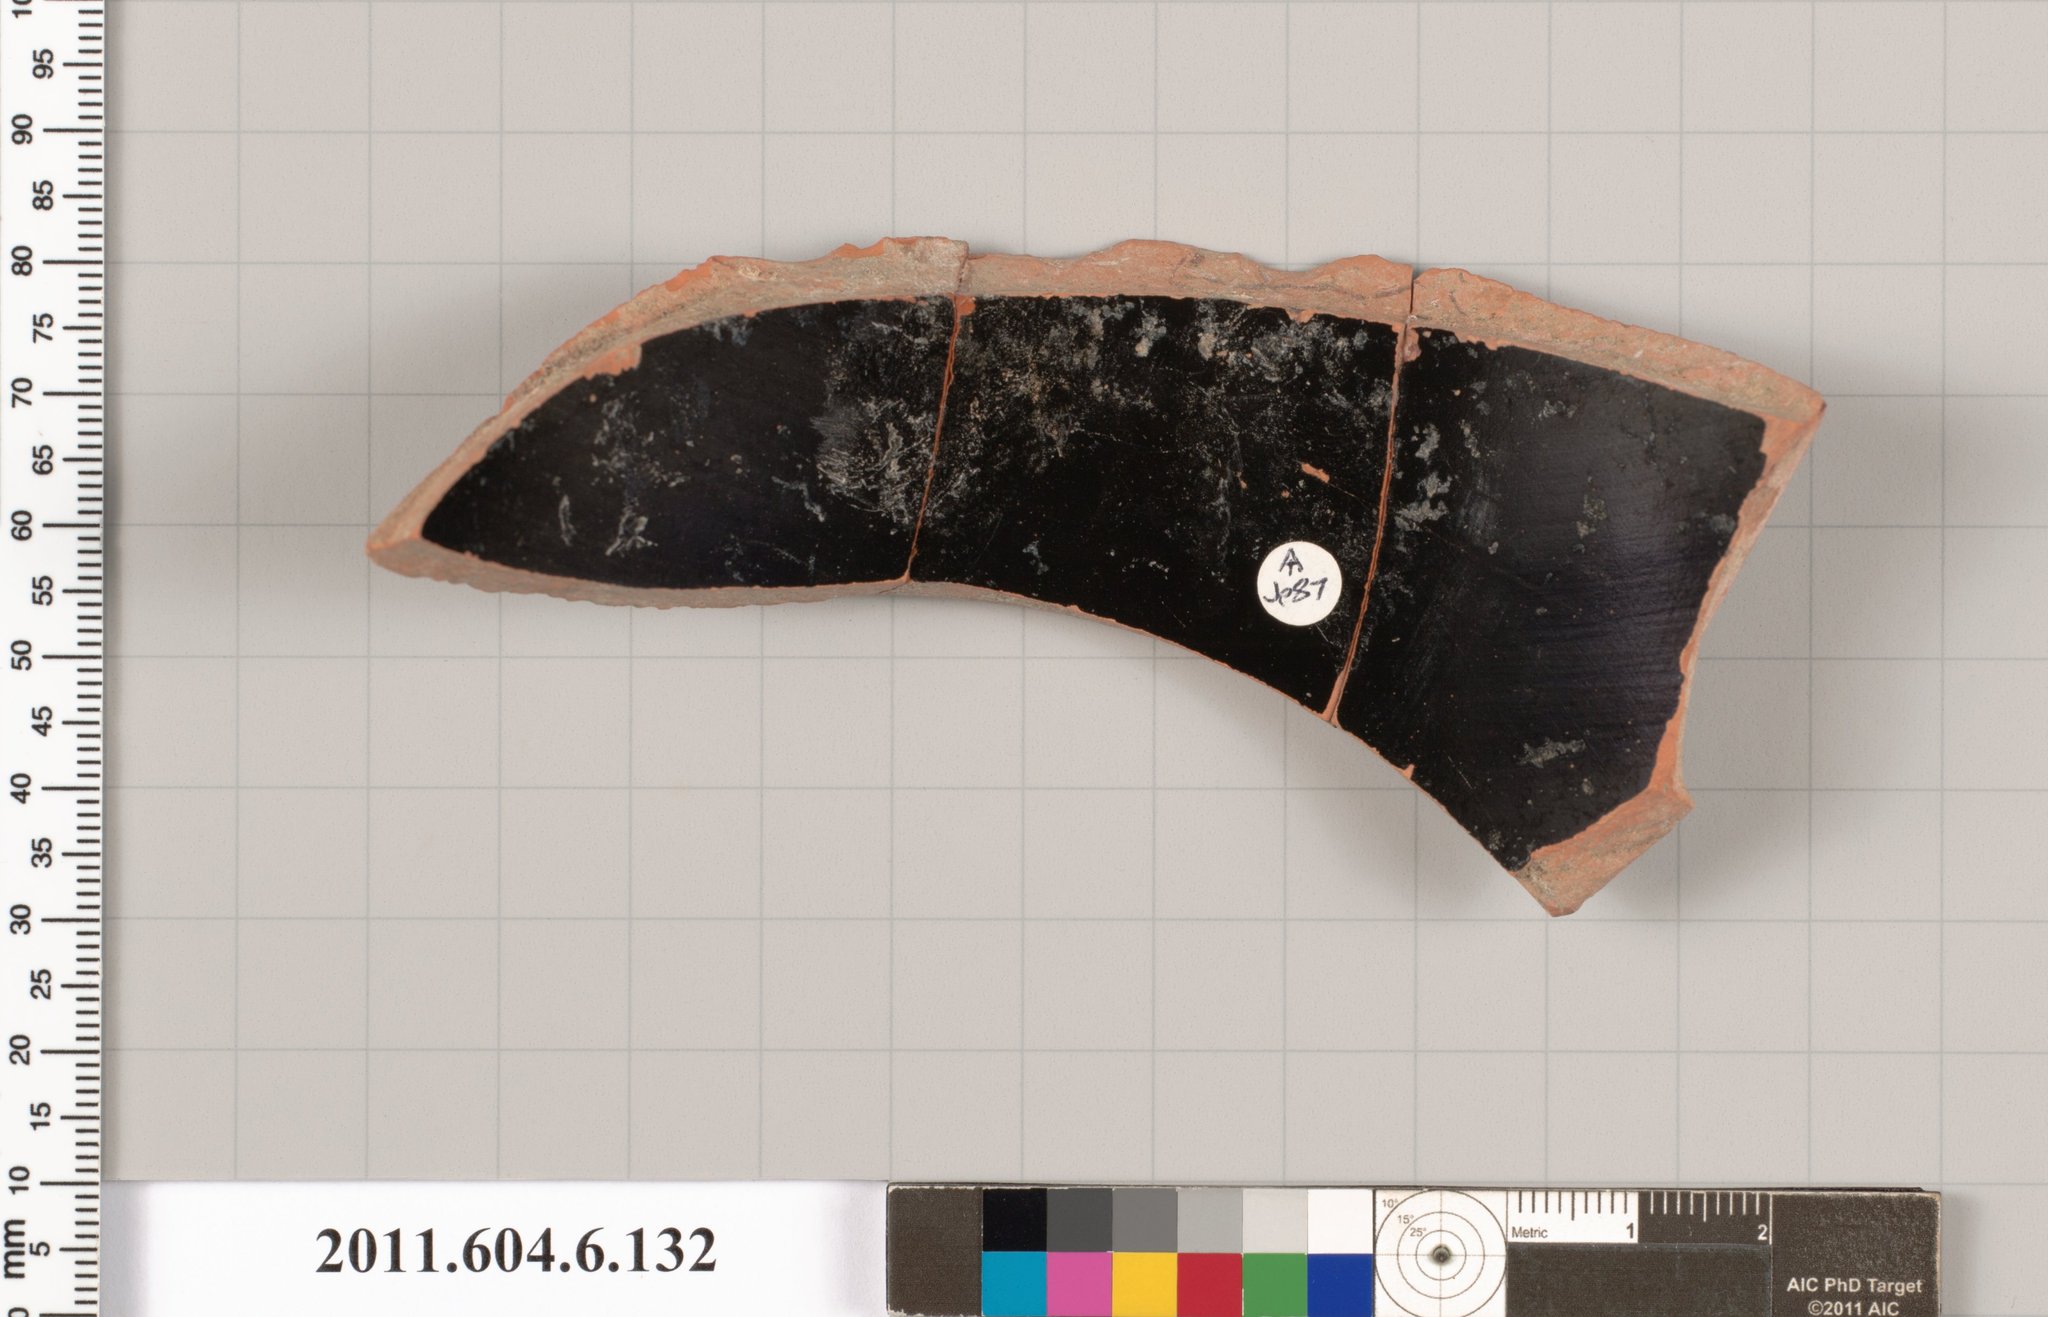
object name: undetermined open shape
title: Terracotta fragment of an open shape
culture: greek, attic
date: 600-401 BCE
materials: terracotta